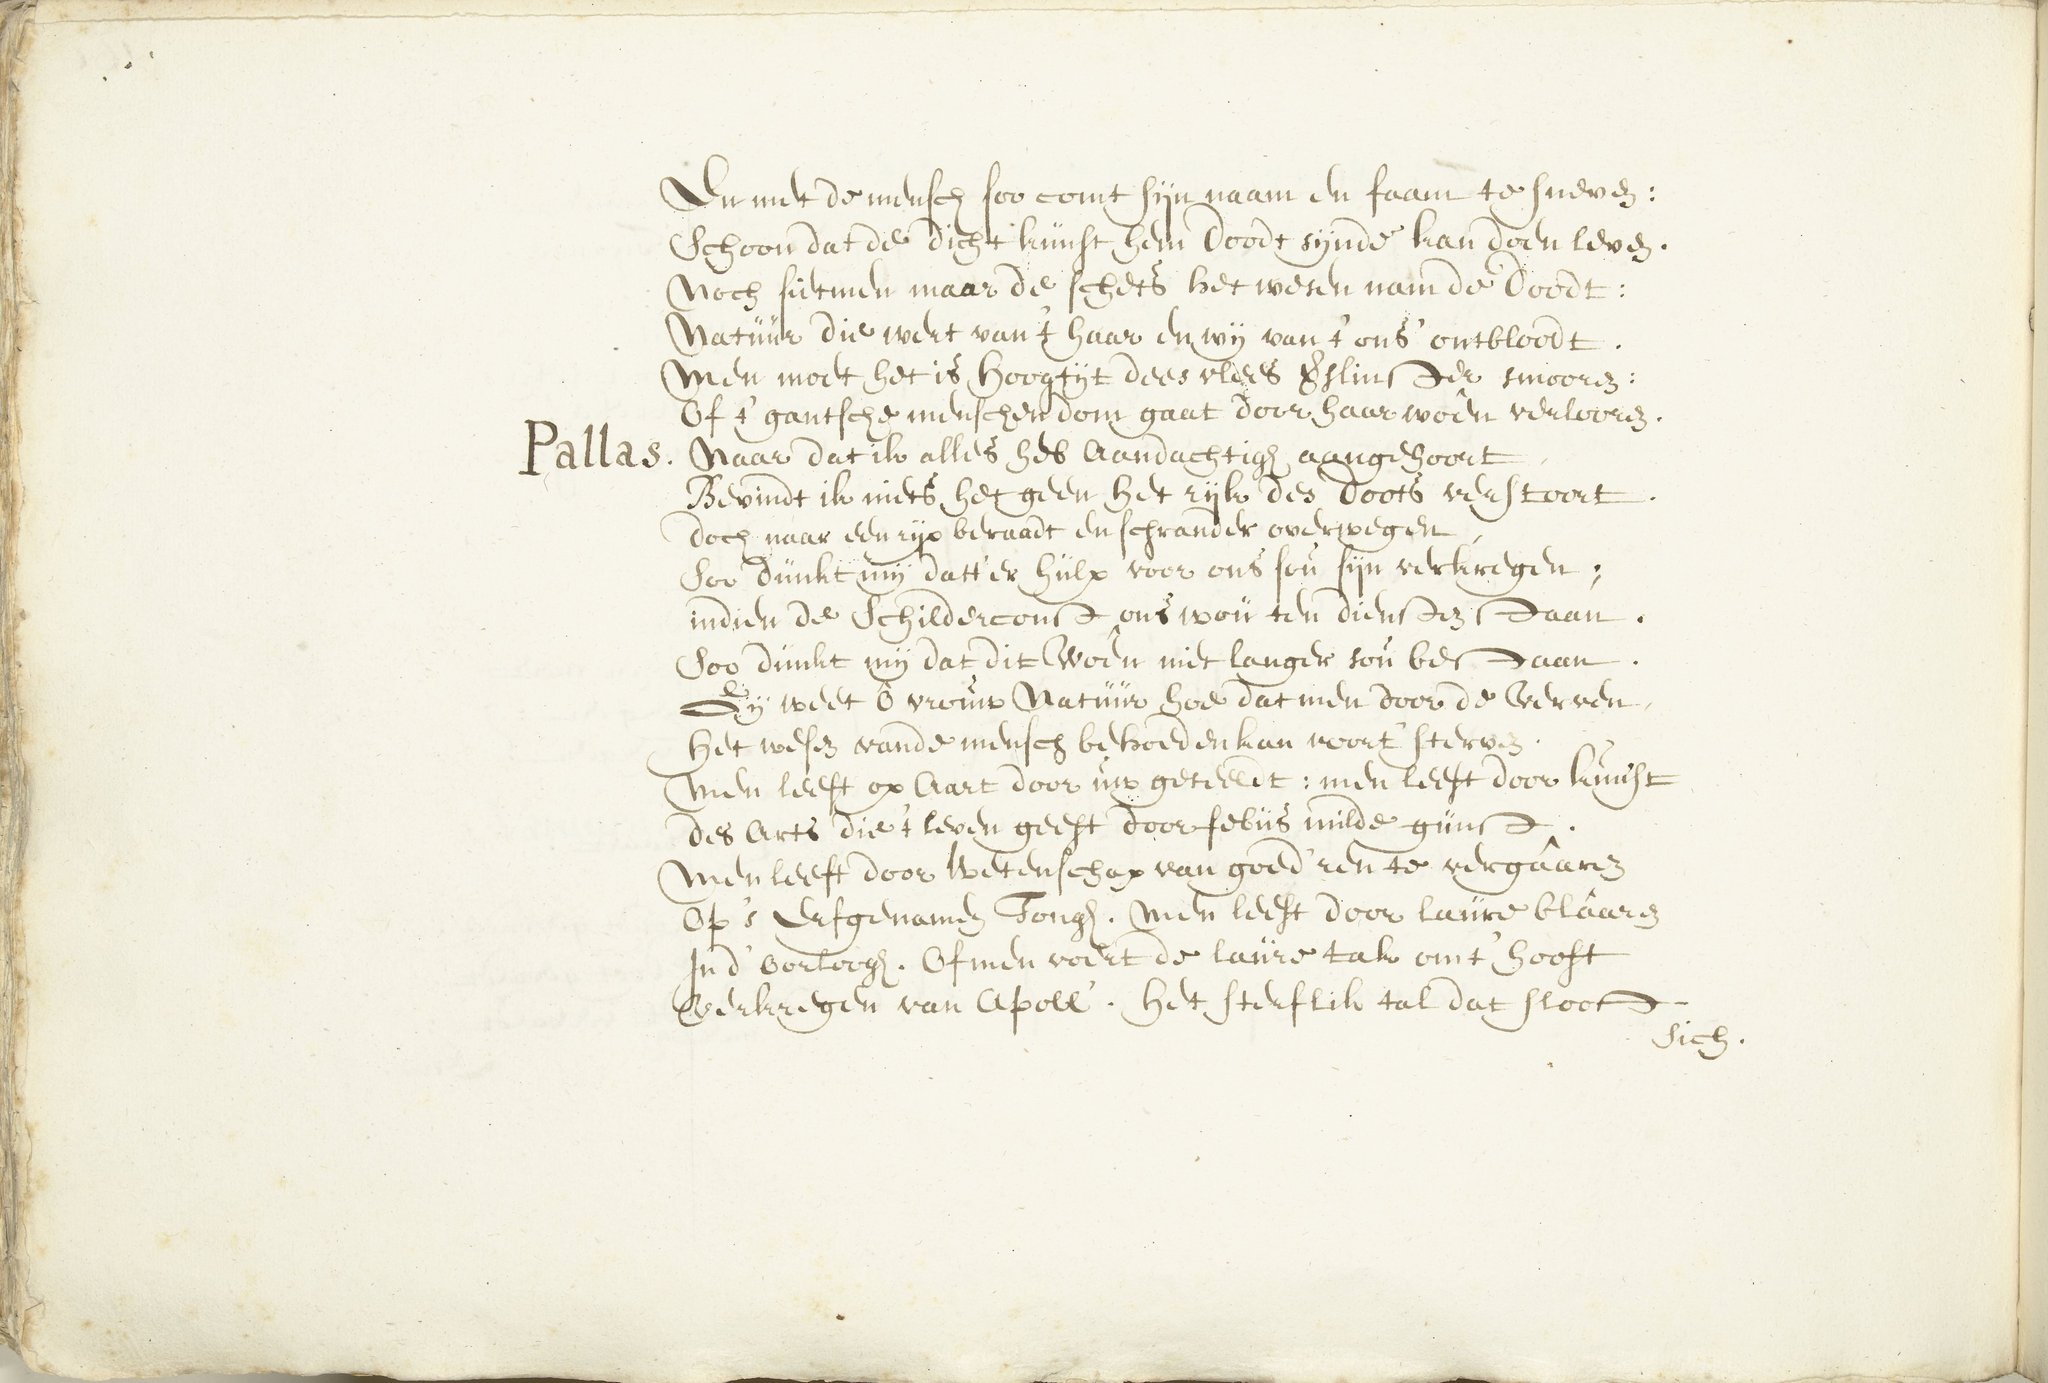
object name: text sheet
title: Strijd tussen Dood en Natuur of Zege der Schilderkunst (deel 8)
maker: henrik jordis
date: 1660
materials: ink, paper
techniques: writing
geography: zwolle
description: Vervolg van het toneelstuk Gooden Pleijdt ofte Triomphe der Schilderconst over de Doodt. In het toneelstuk beraden Apollo, Mercurius, Pallas Athene en Natuur zich over de manier waarop de Dood overwonnen kan worden en roepen zij de hulp van Schilderkunst in.